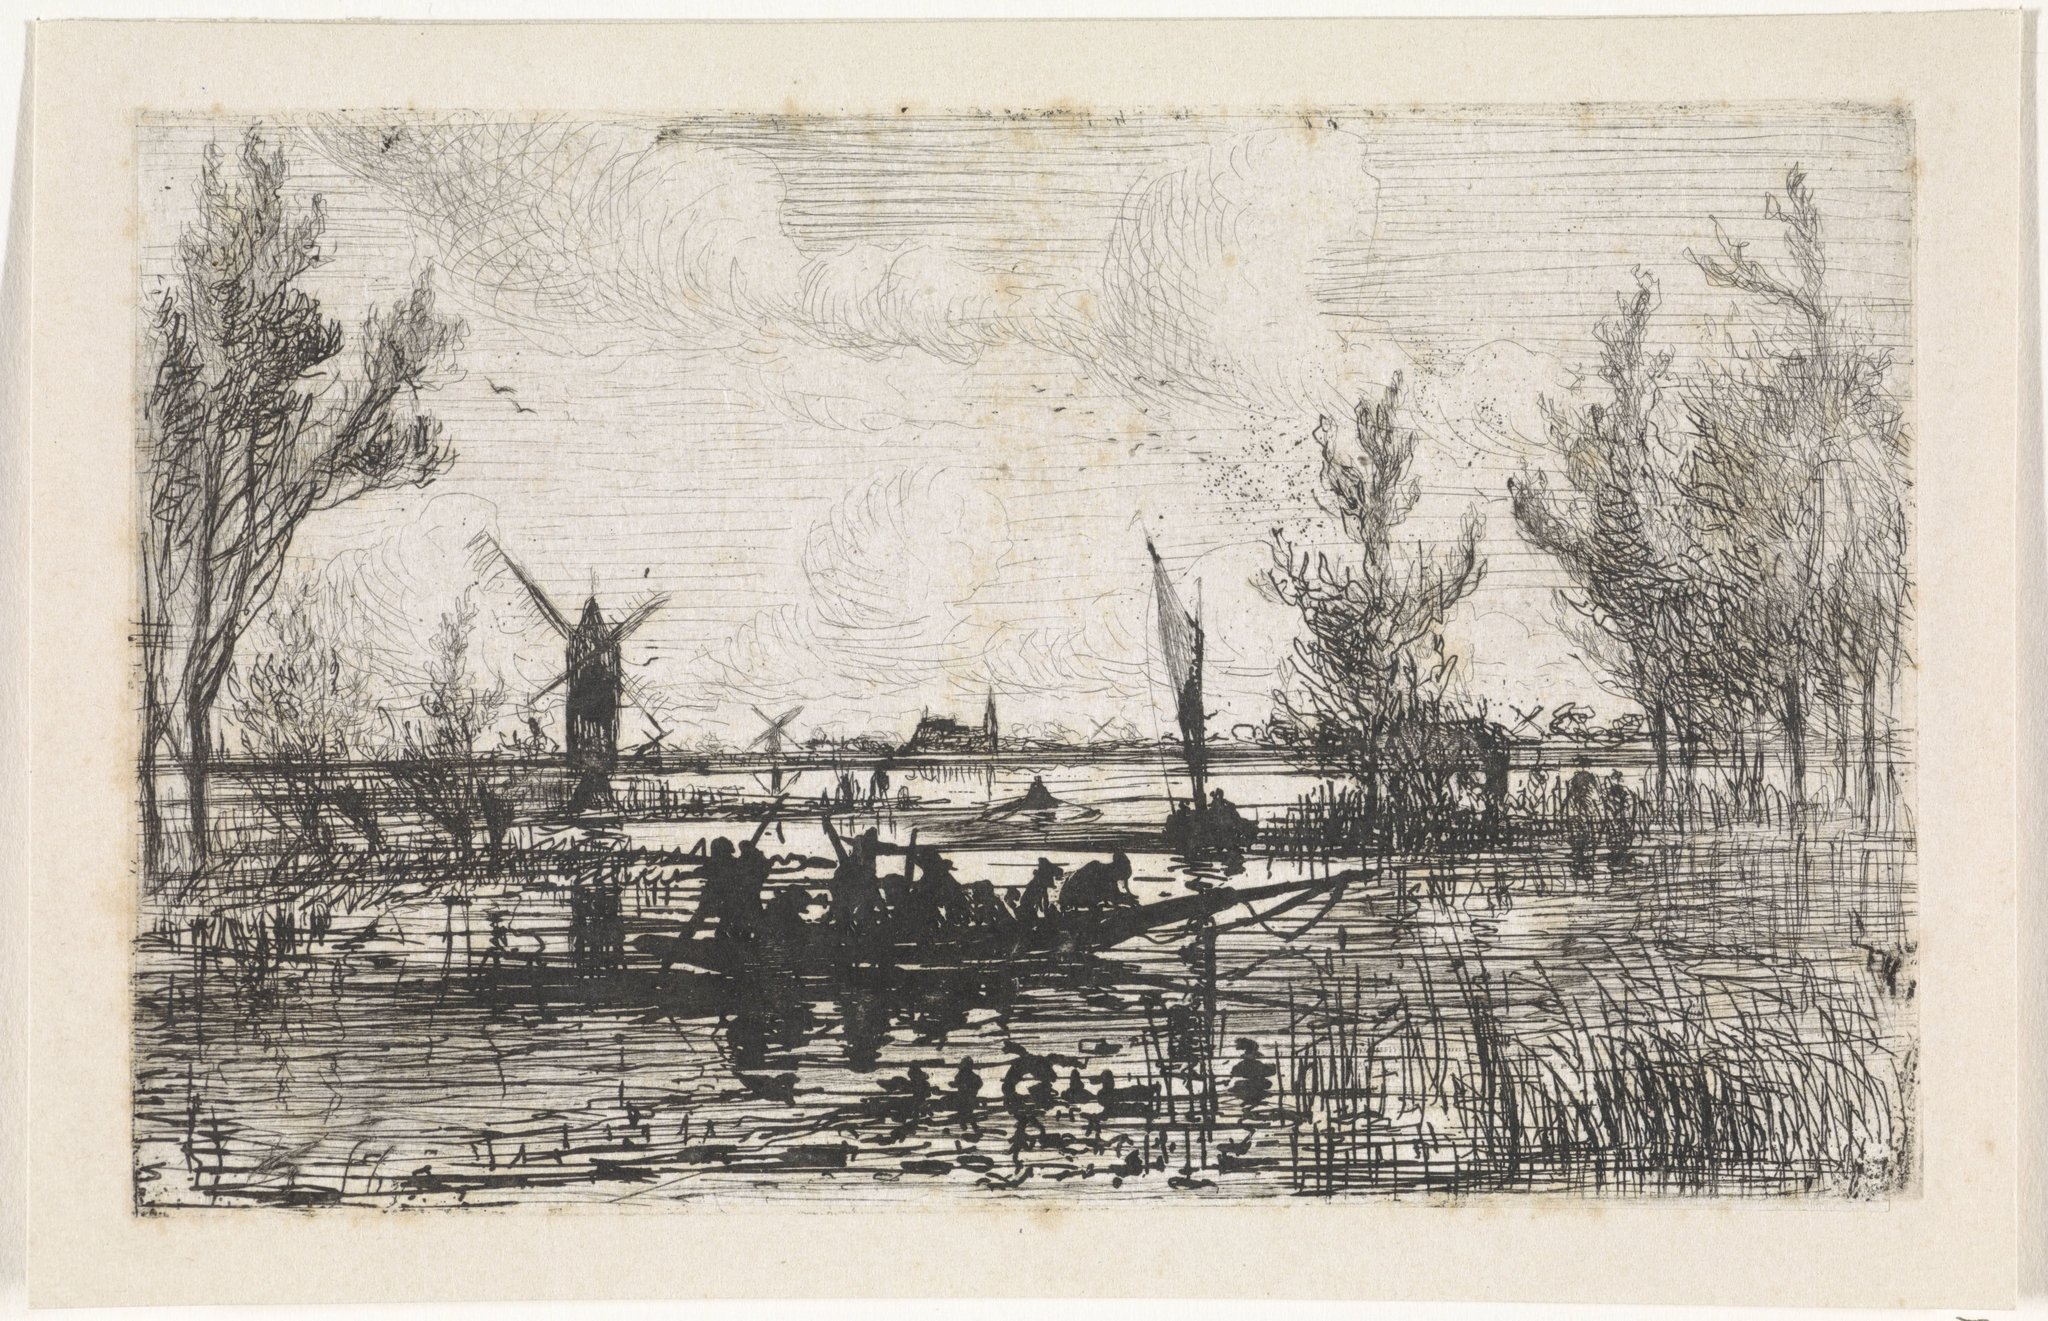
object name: print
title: Hollands landschap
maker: johannes tavenraat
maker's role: draughtsman, painter, print maker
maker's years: 1809-1881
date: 1819-1881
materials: paper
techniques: etching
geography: cleves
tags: rowing-boat, canoe, etc., windmill in landscape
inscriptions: collector's mark: Lugt 2228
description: Landschap met op de voorgrond een boot met passagiers. Aan de horizon een molen.